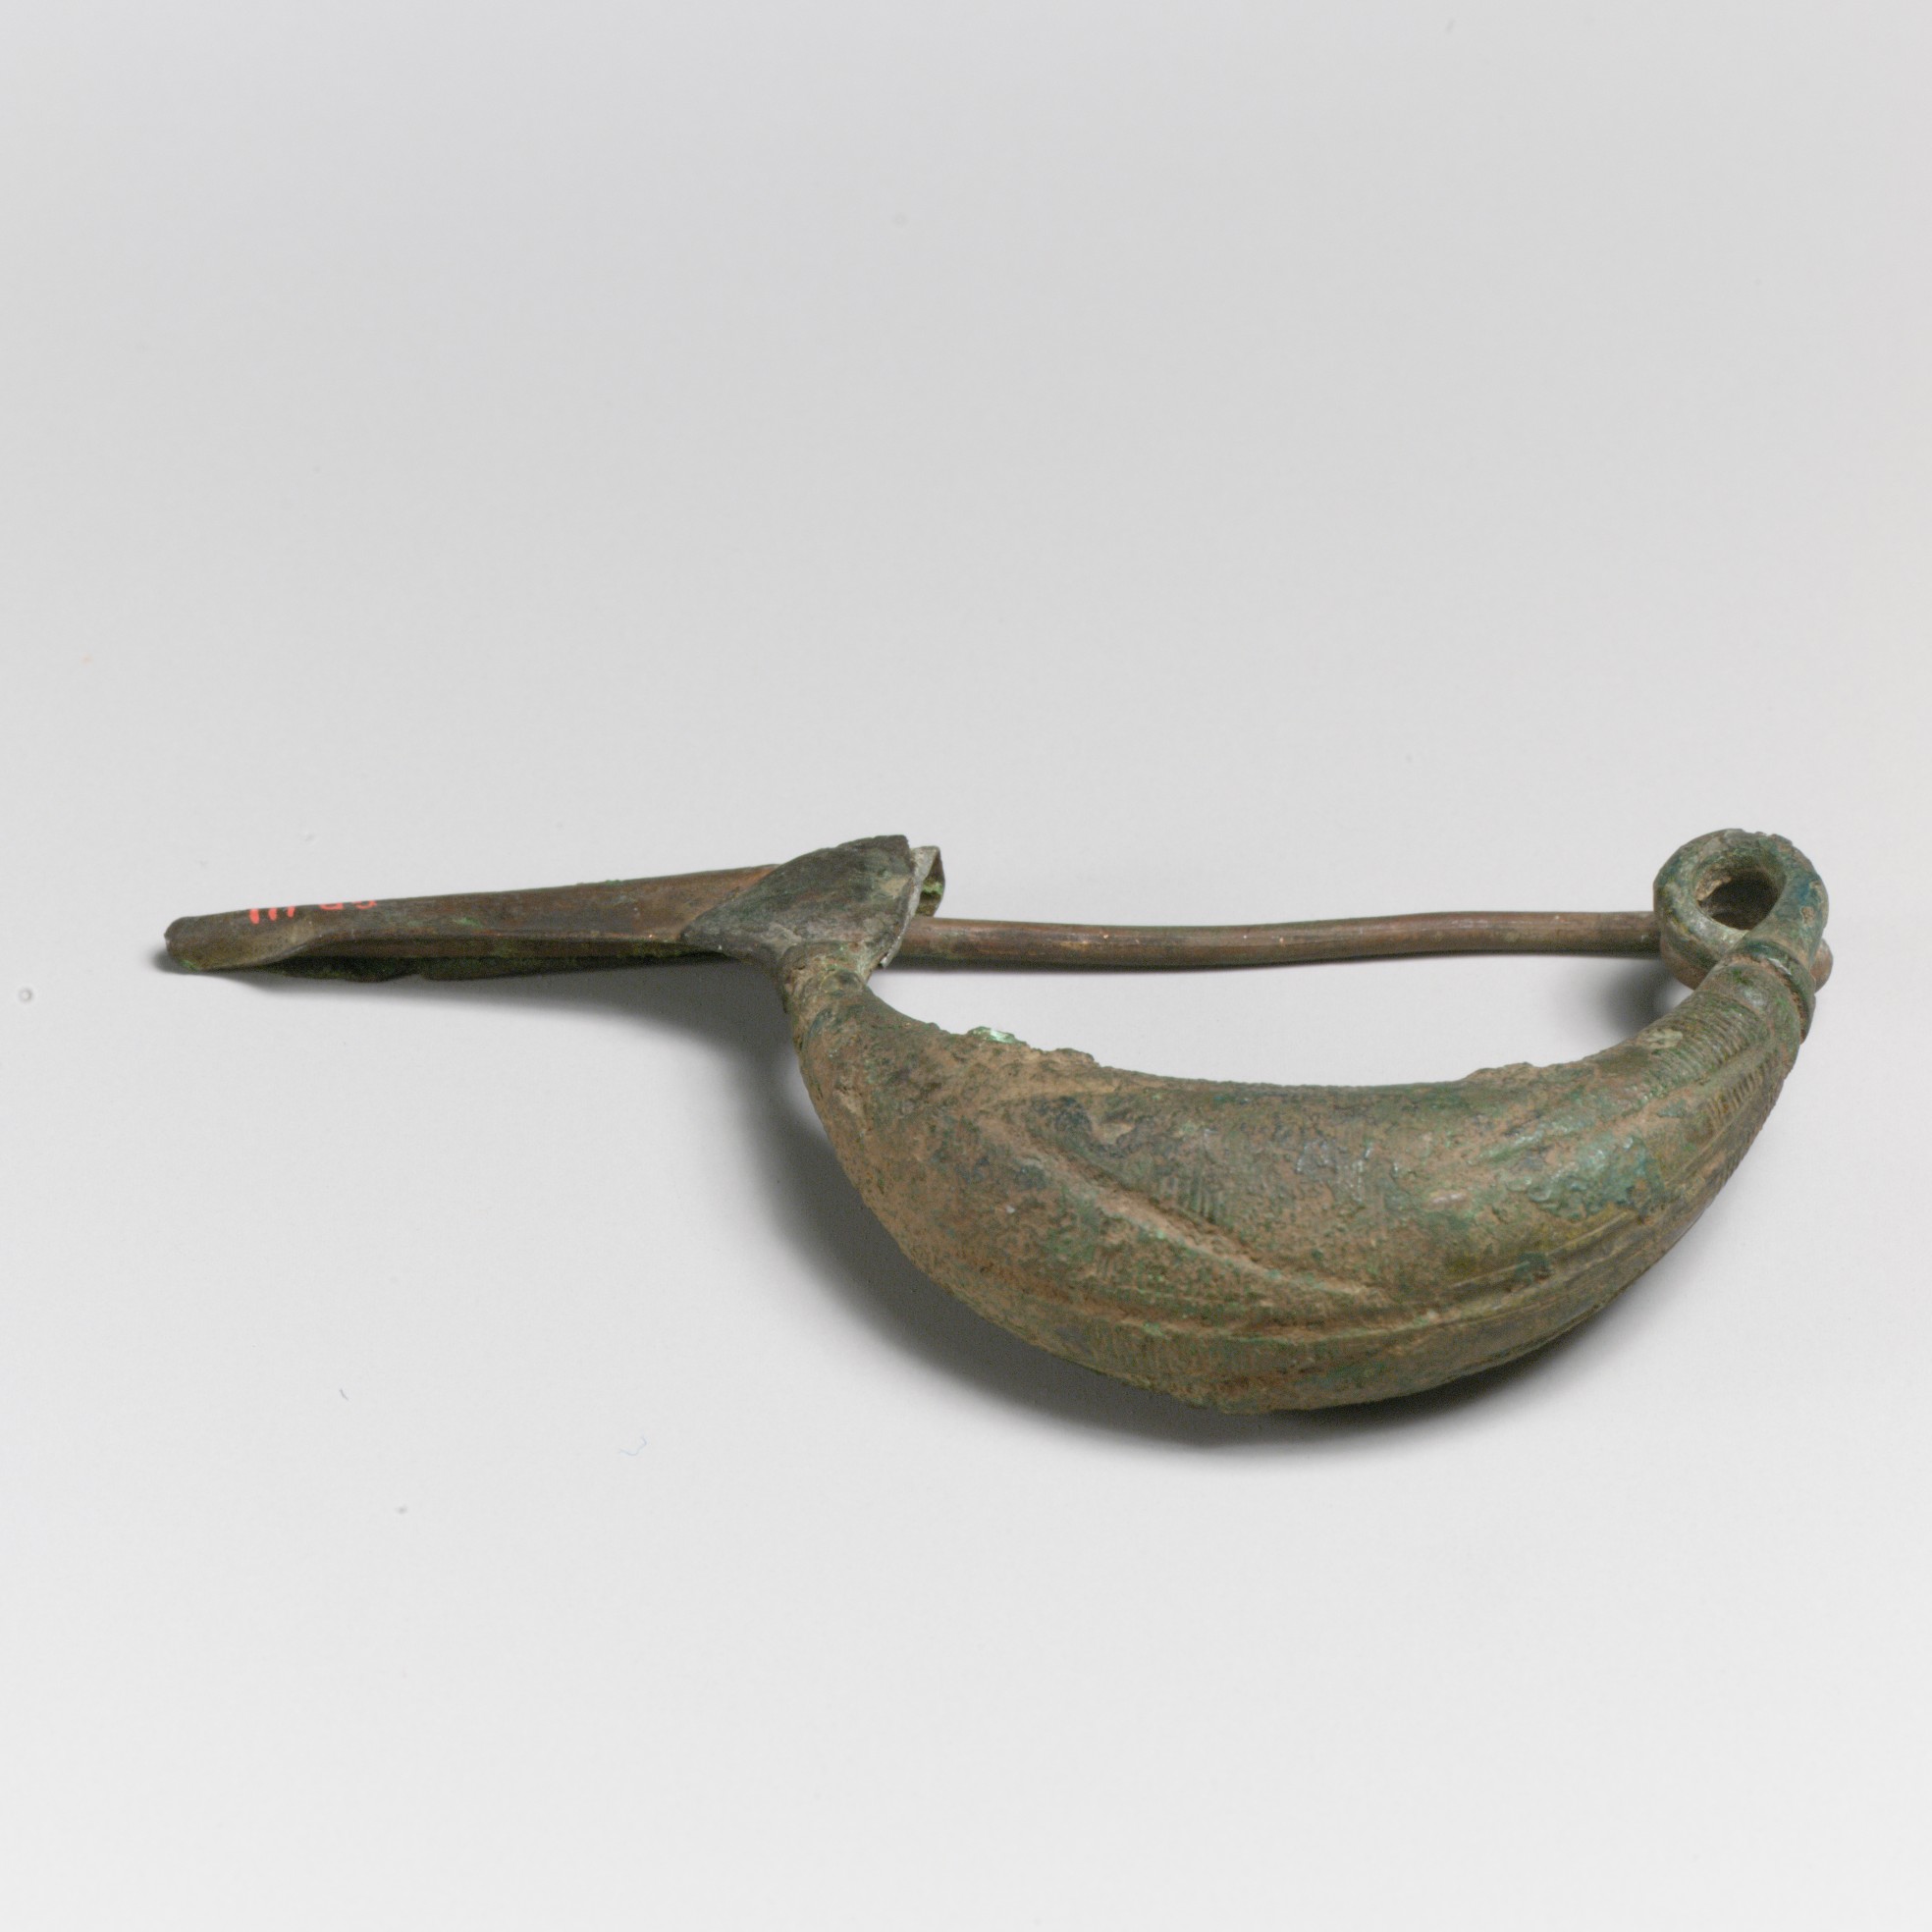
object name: fibula, boat shaped type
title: Fibula, boat-shaped type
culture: italic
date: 800-501 BCE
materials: bronze